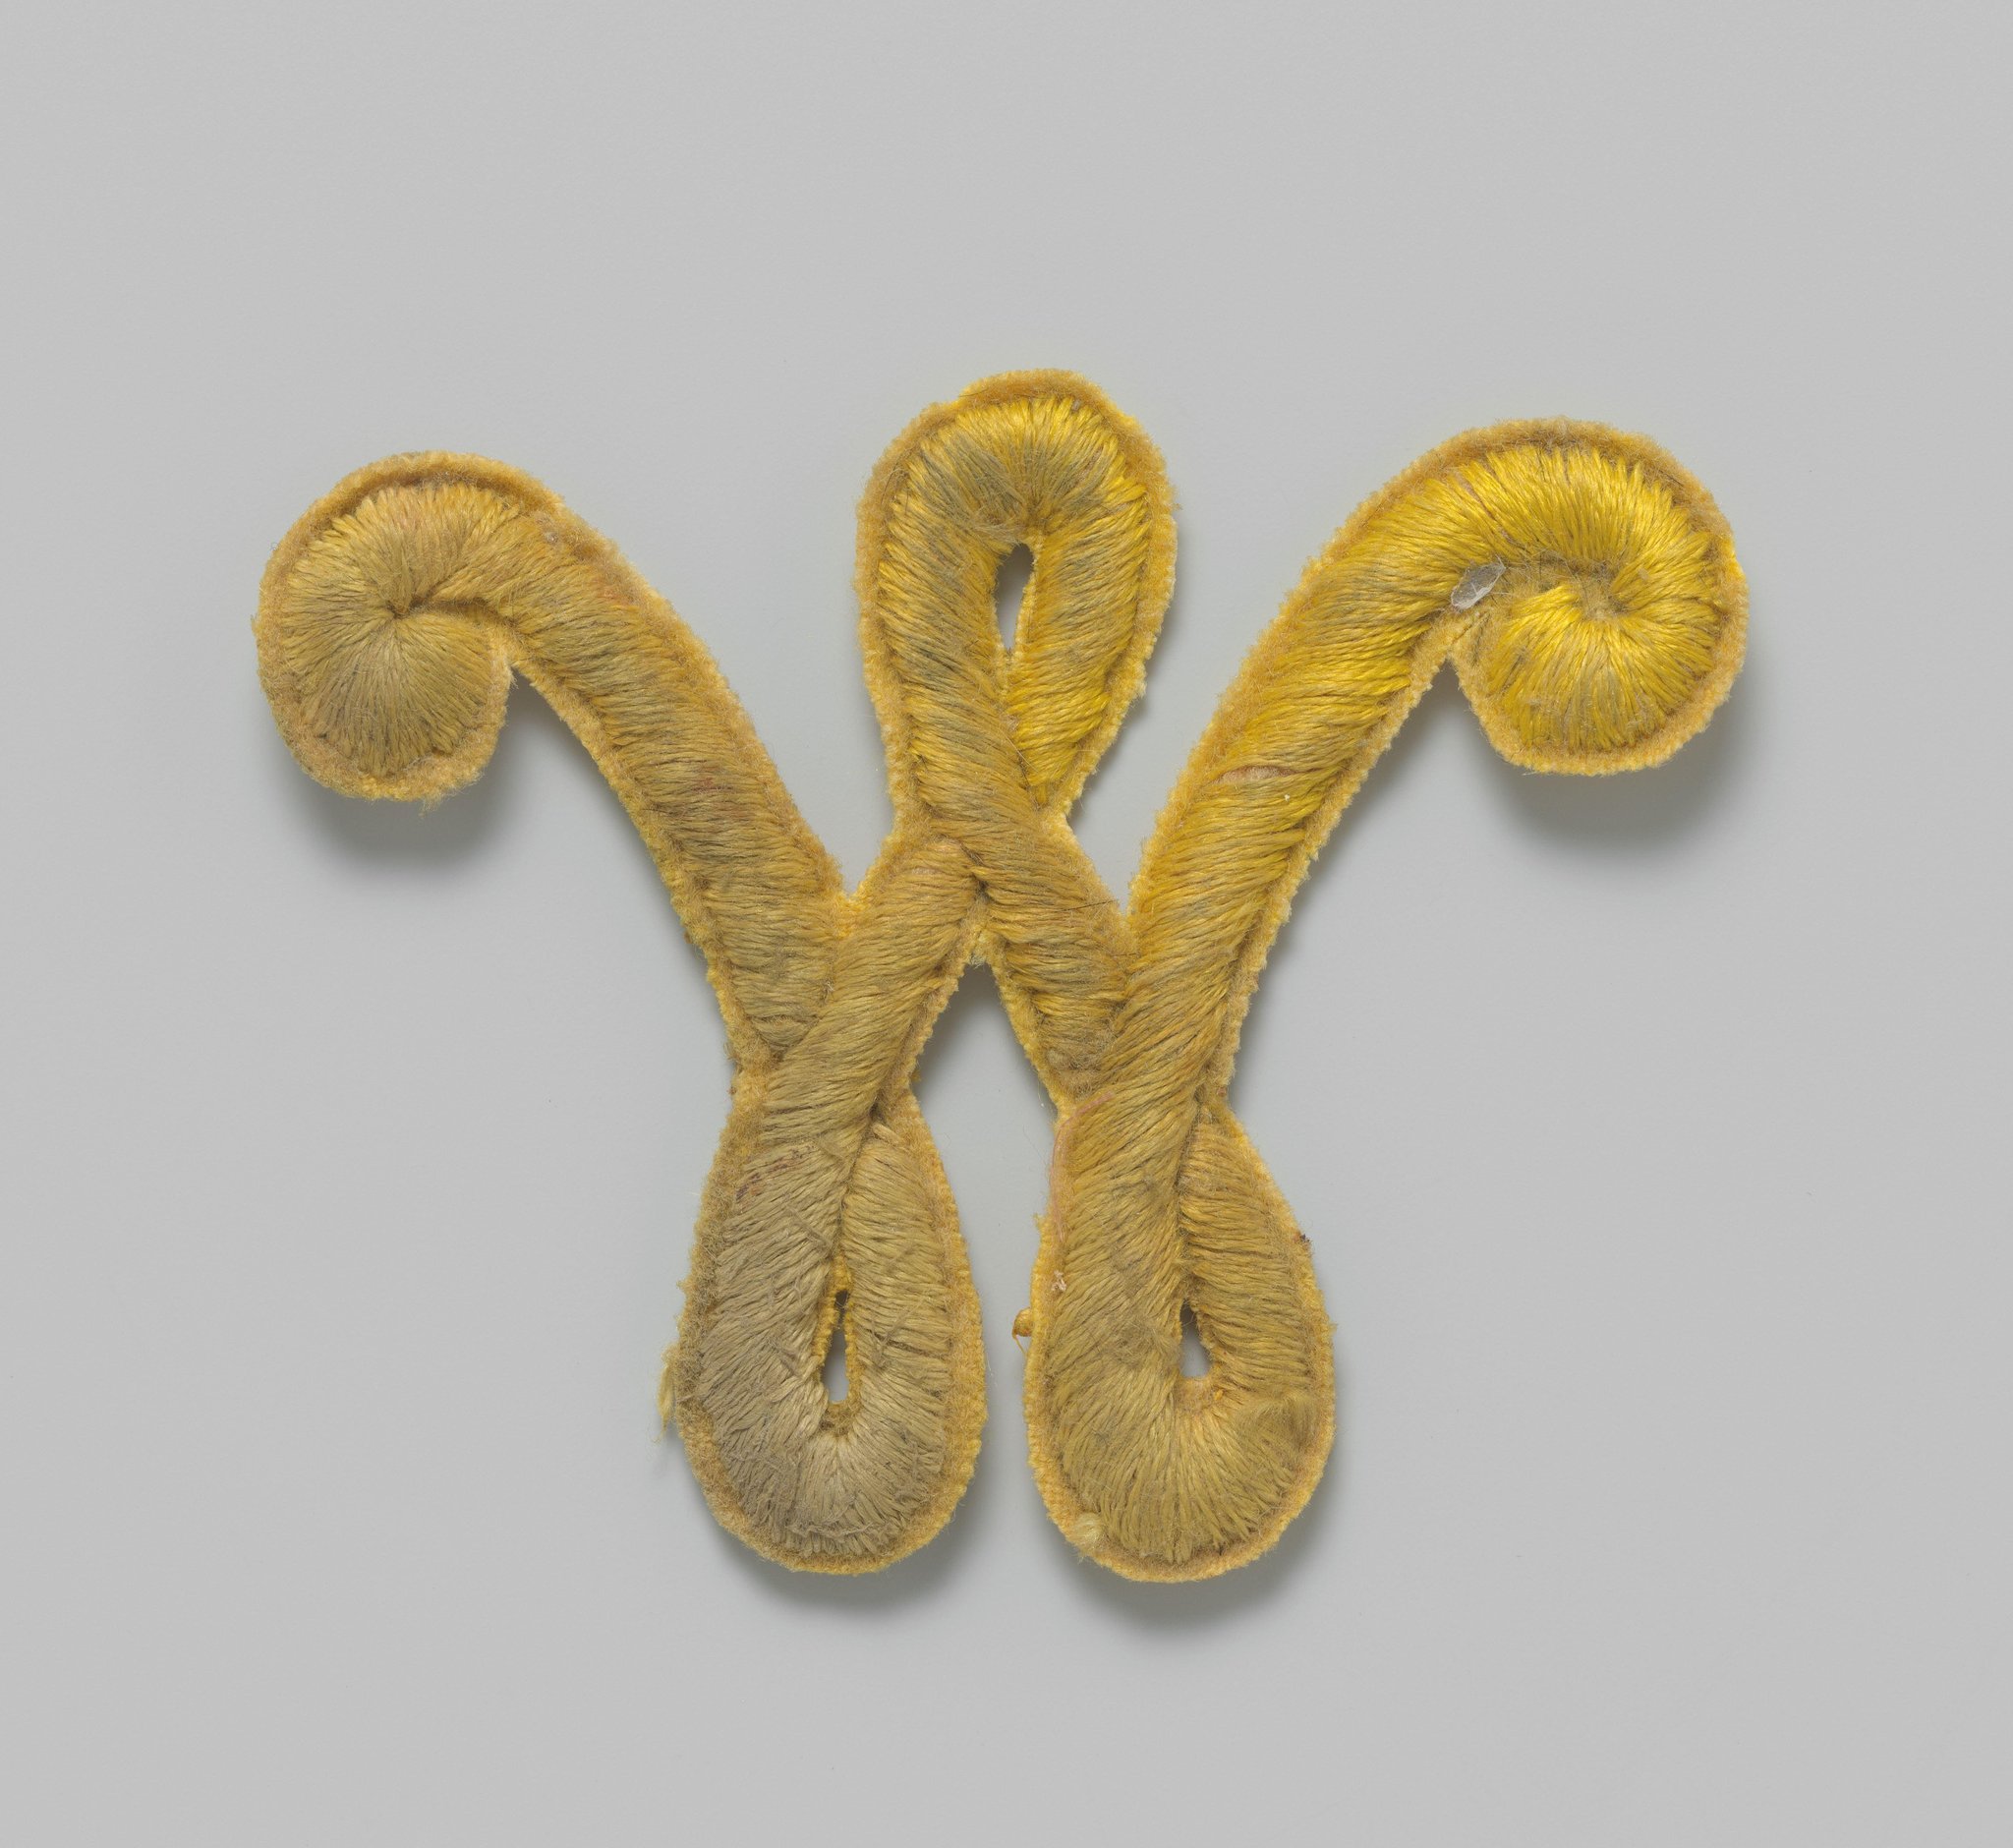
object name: applicatie textiel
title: Applicatie, geborduurd in de vorm van een W in geel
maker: Anonymous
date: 1850-1899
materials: textile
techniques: embroidered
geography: netherlands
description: Applicatie, geborduurd in de vorm van een W in geel.